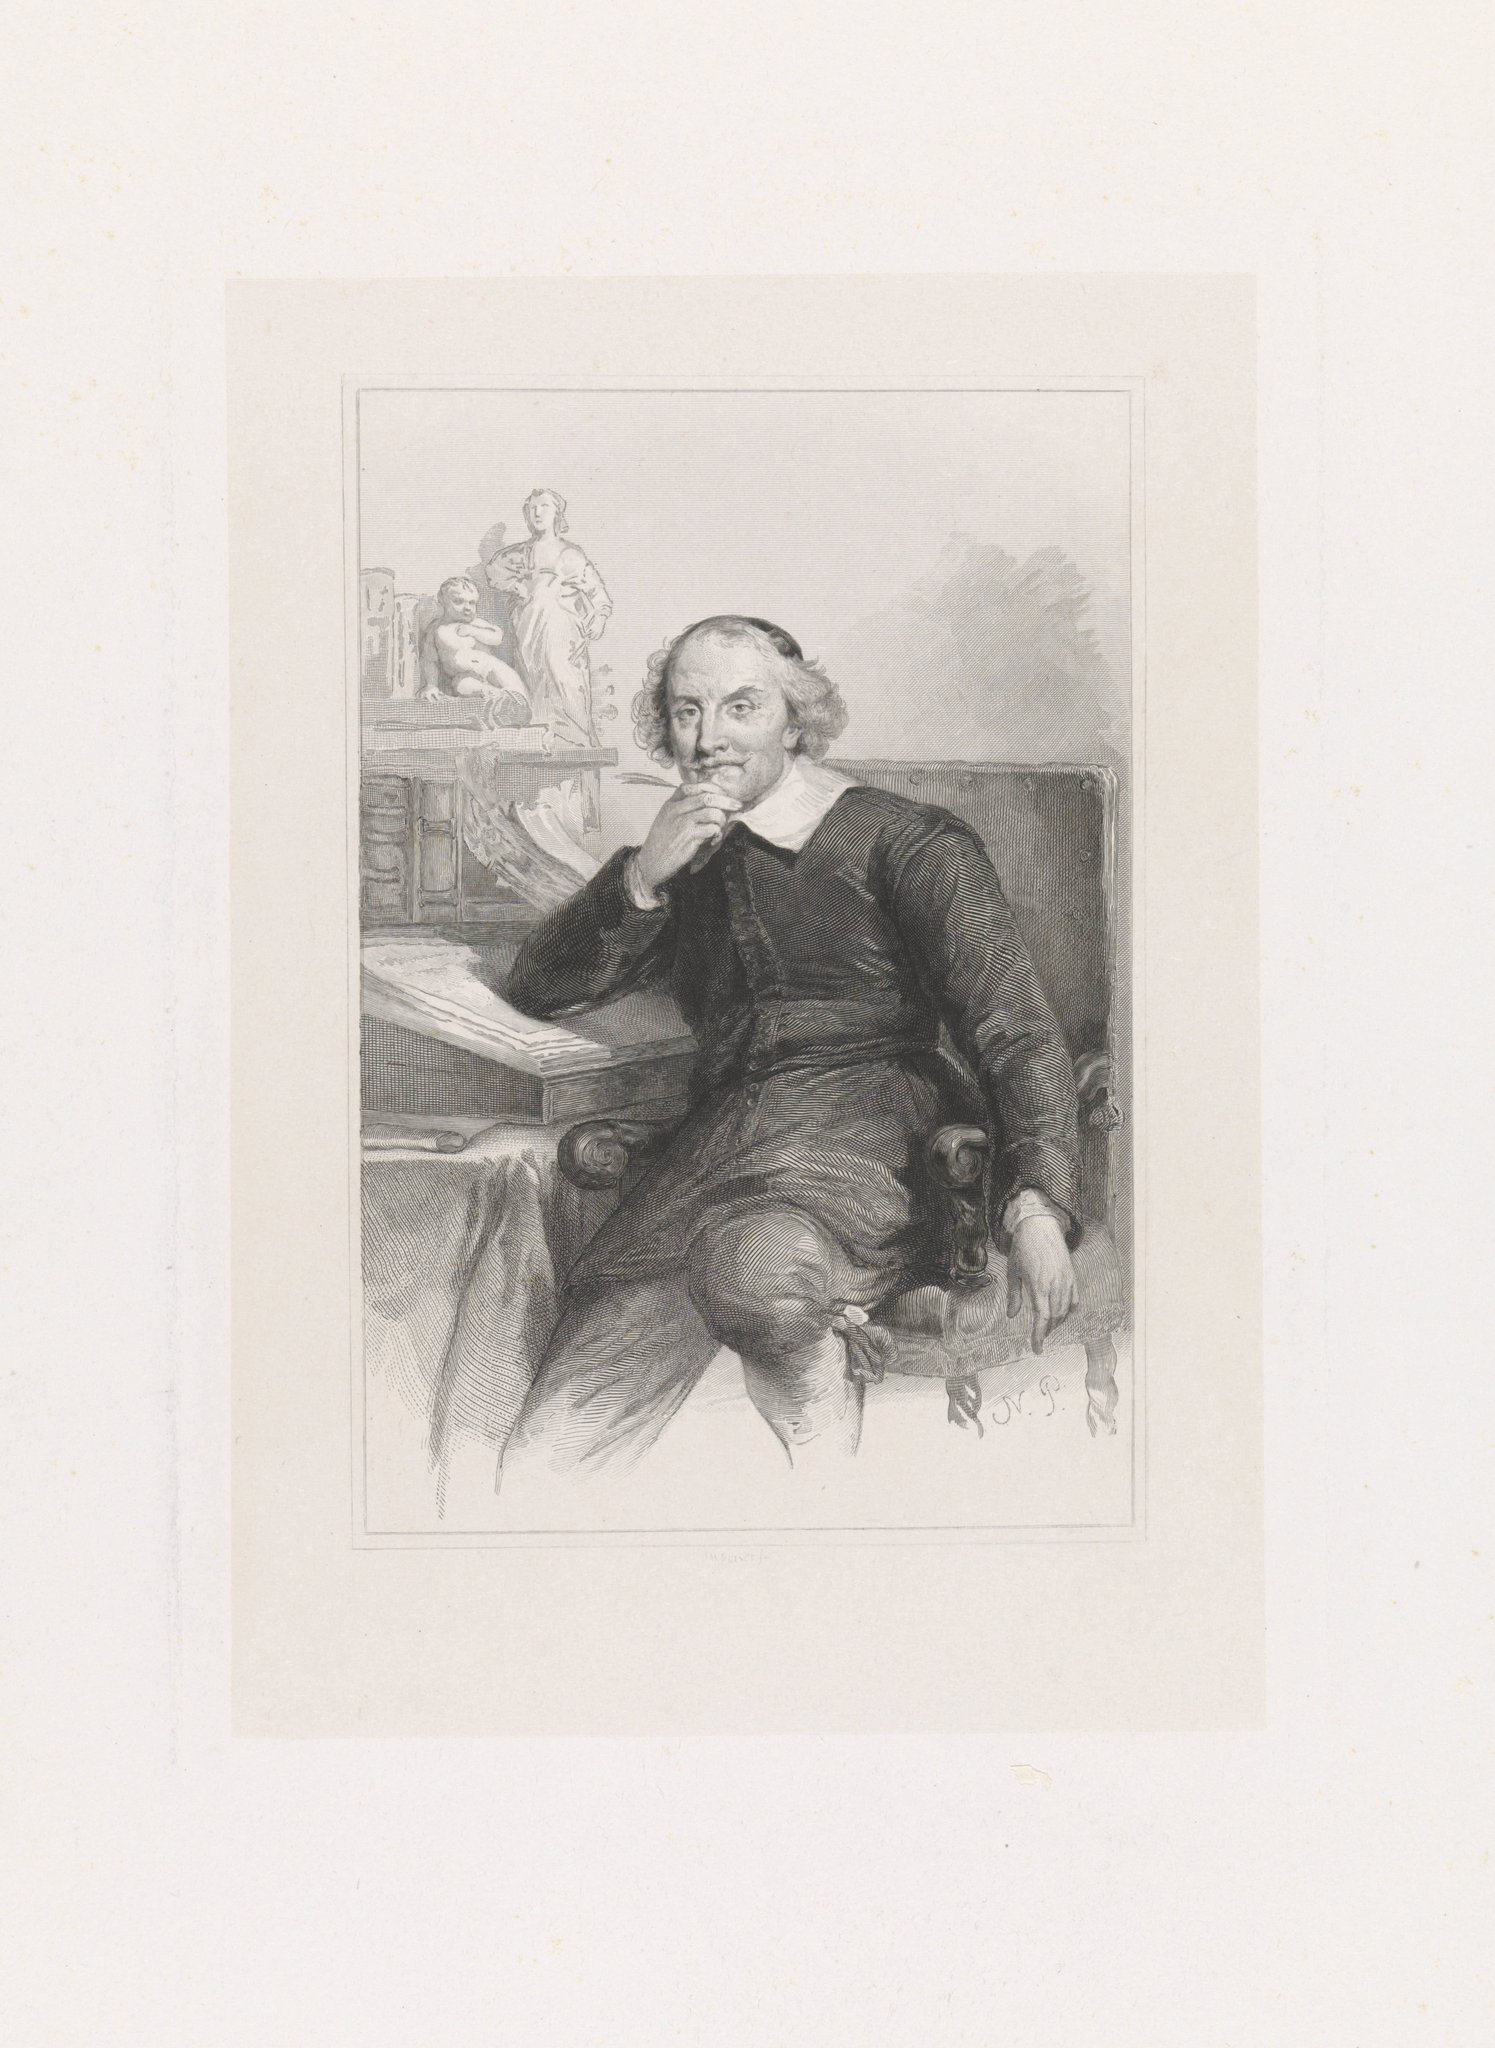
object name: print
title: Portret van Joost van den Vondel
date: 1823-1900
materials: paper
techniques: etching, roulette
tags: amsterdam, joost van den vondel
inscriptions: collector's mark: Lugt 2228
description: Portret van de dichter Joost van den Vondel, zittend aan een bureau. Hij draagt een kalot en heeft een schrijfveer in zijn rechterhand.